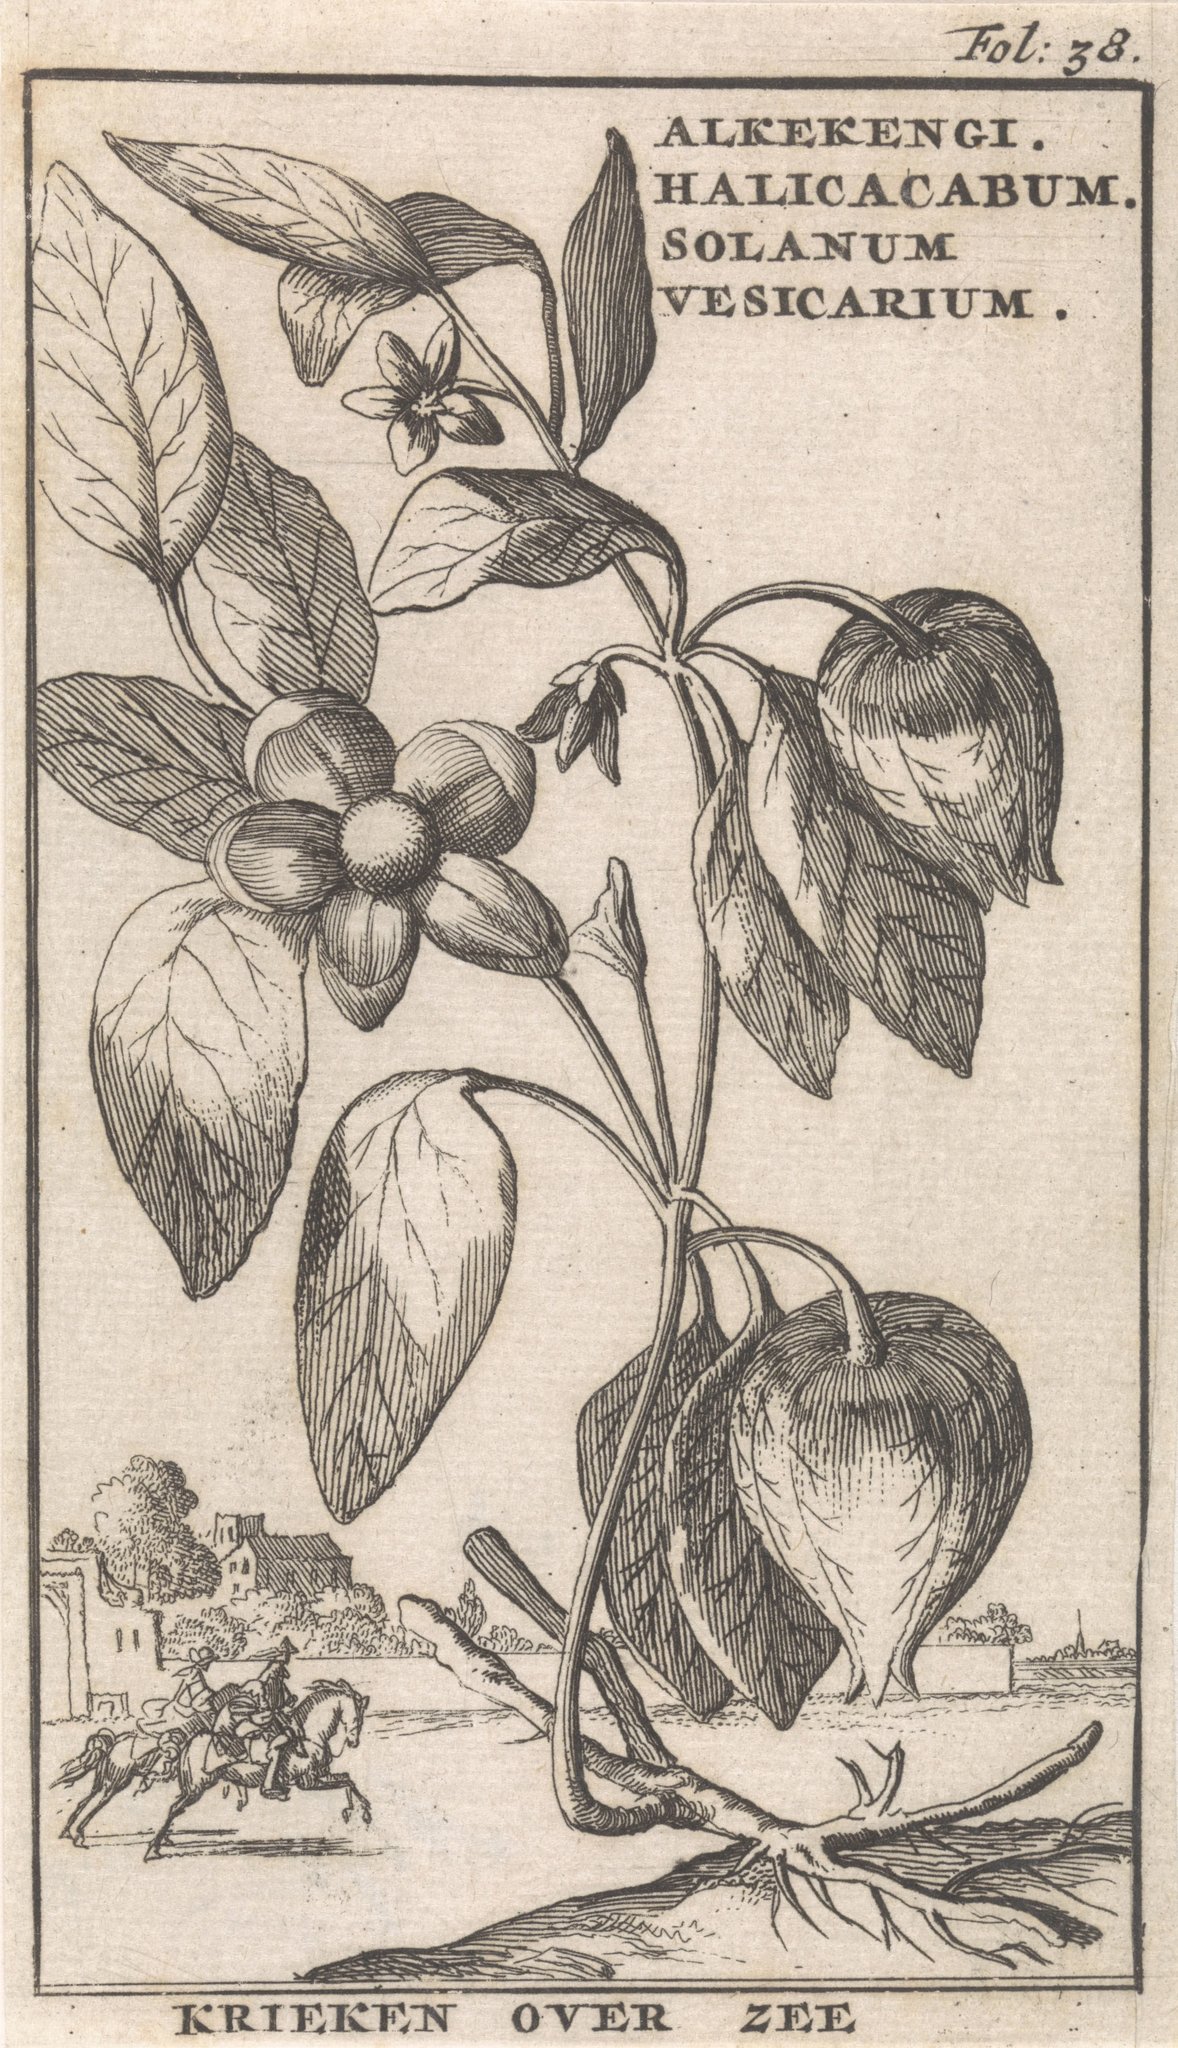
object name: print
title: Lampionplant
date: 1698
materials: paper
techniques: etching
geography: amsterdam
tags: plants and herbs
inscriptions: collector's mark: Lugt 2228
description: Illustratie uit: Blankaart, Steven. Den Neder-landschen herbarius ofte Kruid-boek der voornaamste kruiden. Amsterdam: Jan Claesz ten Hoorn, 1698.